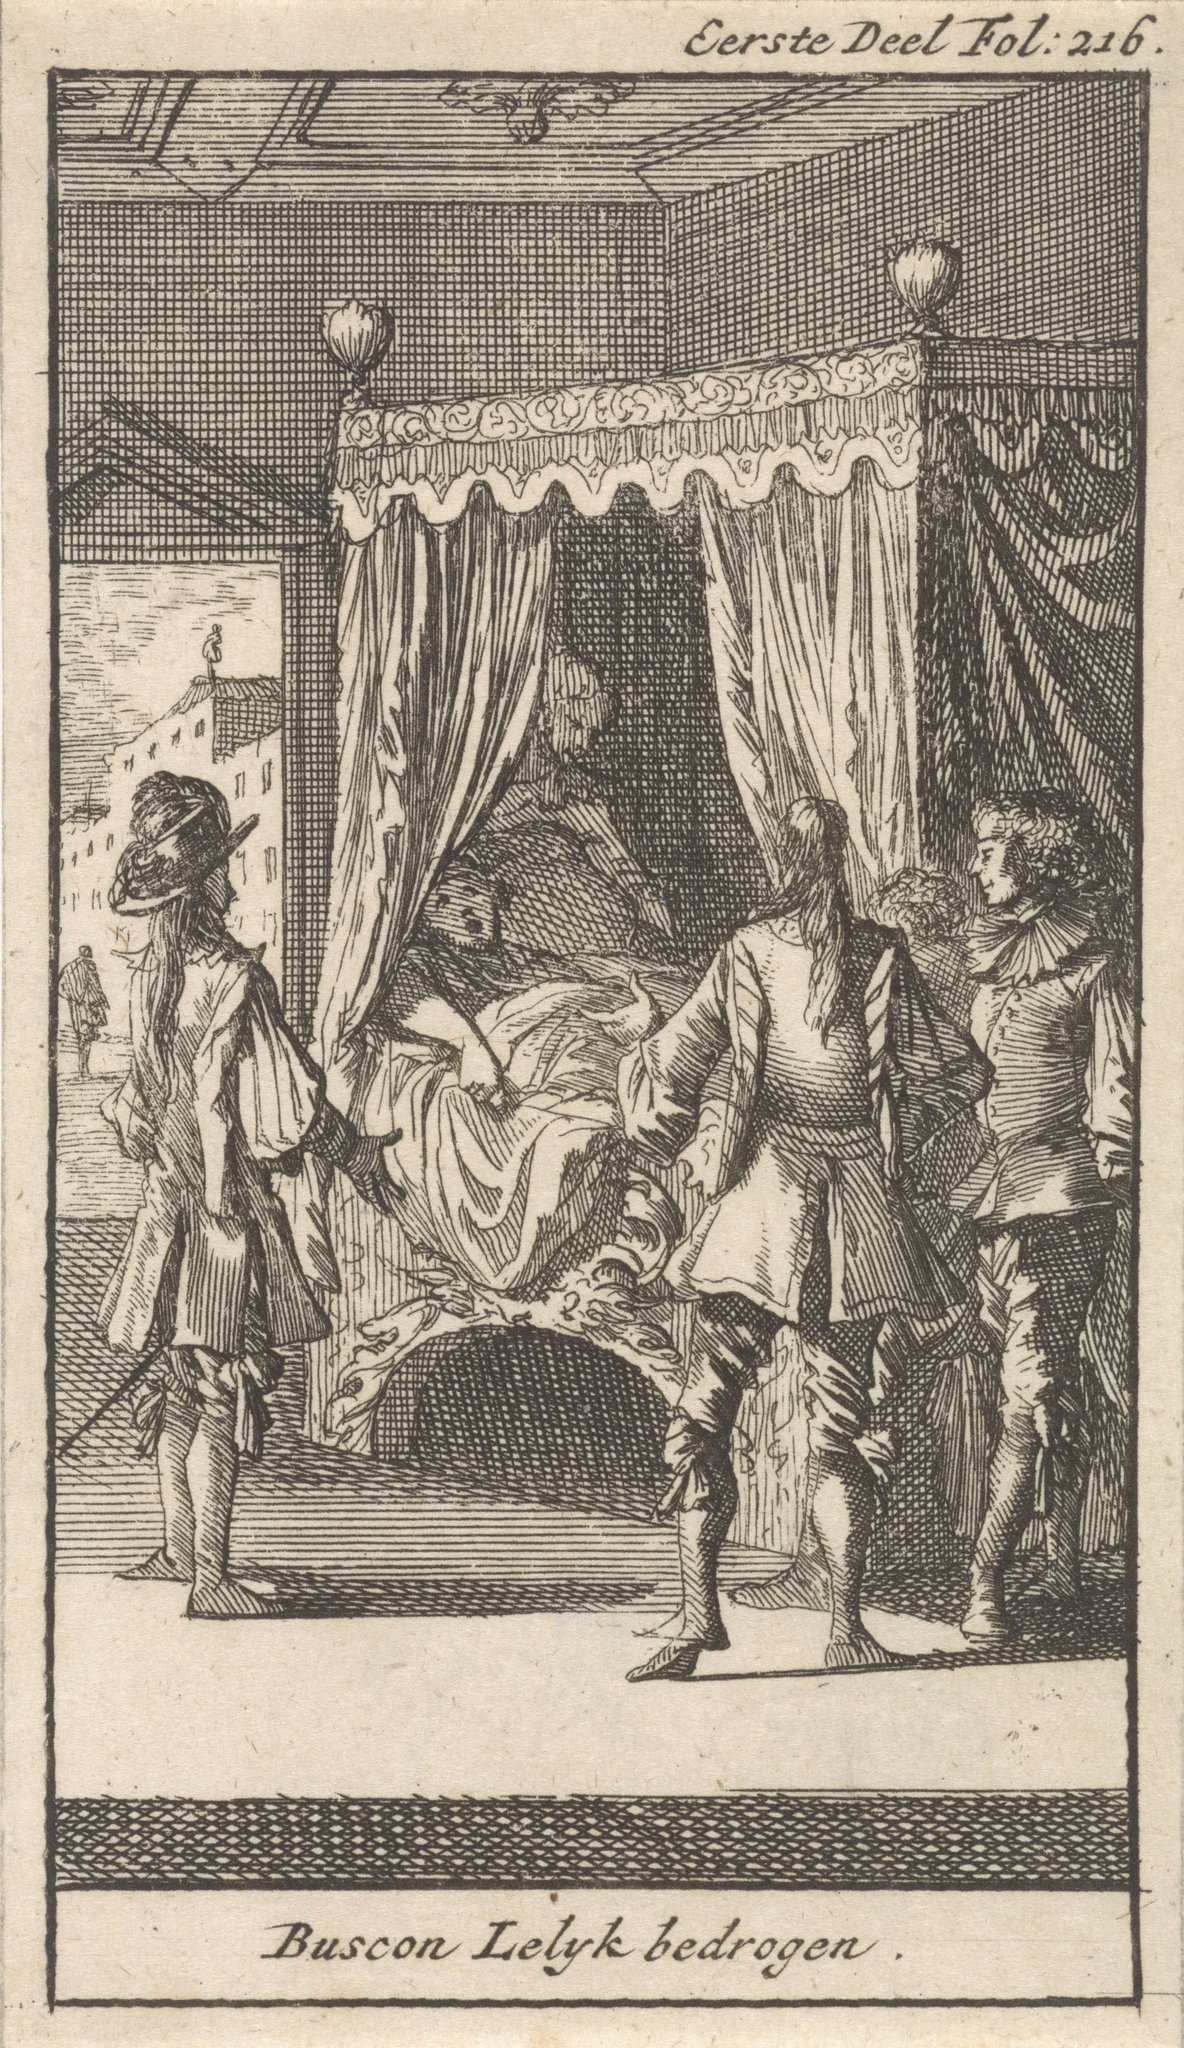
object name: book illustration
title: Buscon Lelyk bedrogen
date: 1699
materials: paper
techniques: etching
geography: leiden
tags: male literary characters (with name), bed, waking up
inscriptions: collector's mark: Lugt 2228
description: Boekillustratie voor Quevedo, Francisco Gómez de. De vol-Geestige Werken van Don Francisco de Quevedo, Villegas. Amsterdam: Jan ten hoorn, 1699, dl. 1, f. 216.